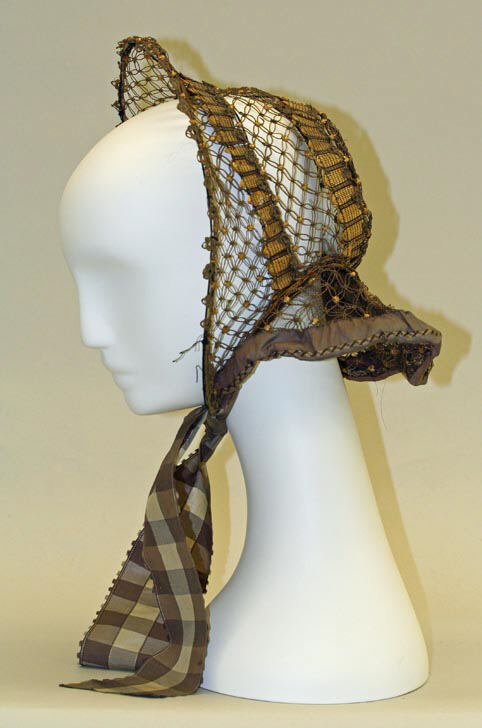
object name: bonnet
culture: american or european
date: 1860-1869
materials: hair, fiber